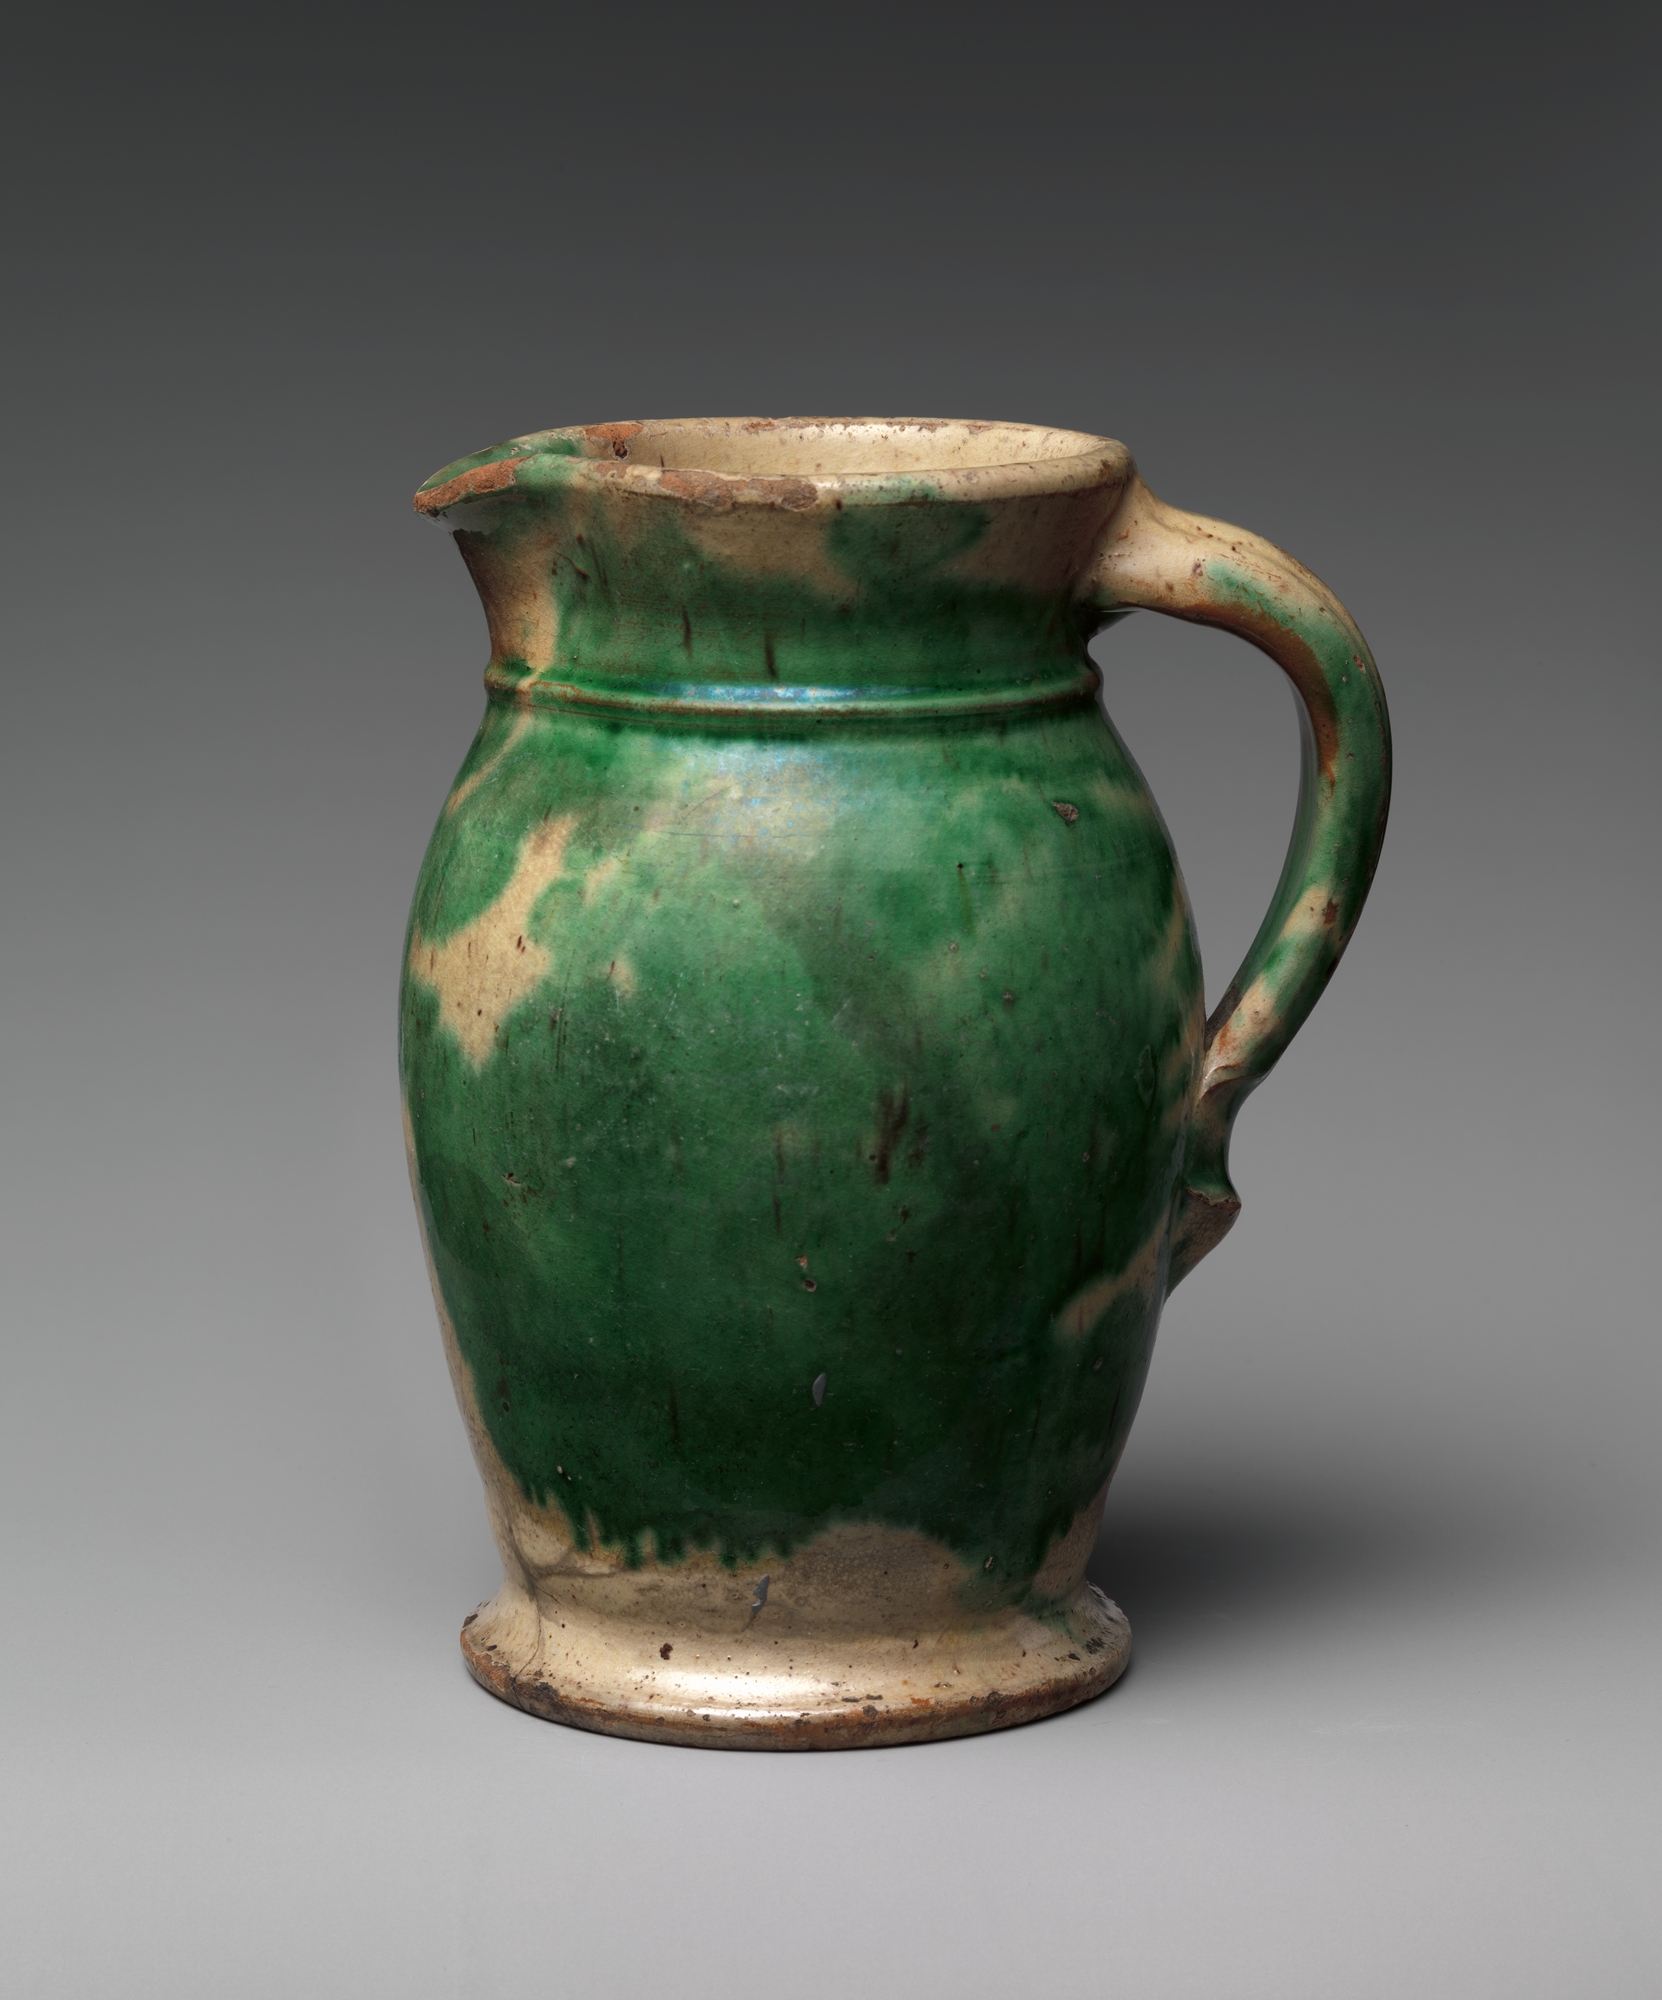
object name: pitcher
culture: american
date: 1800-1900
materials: earthenware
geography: united states